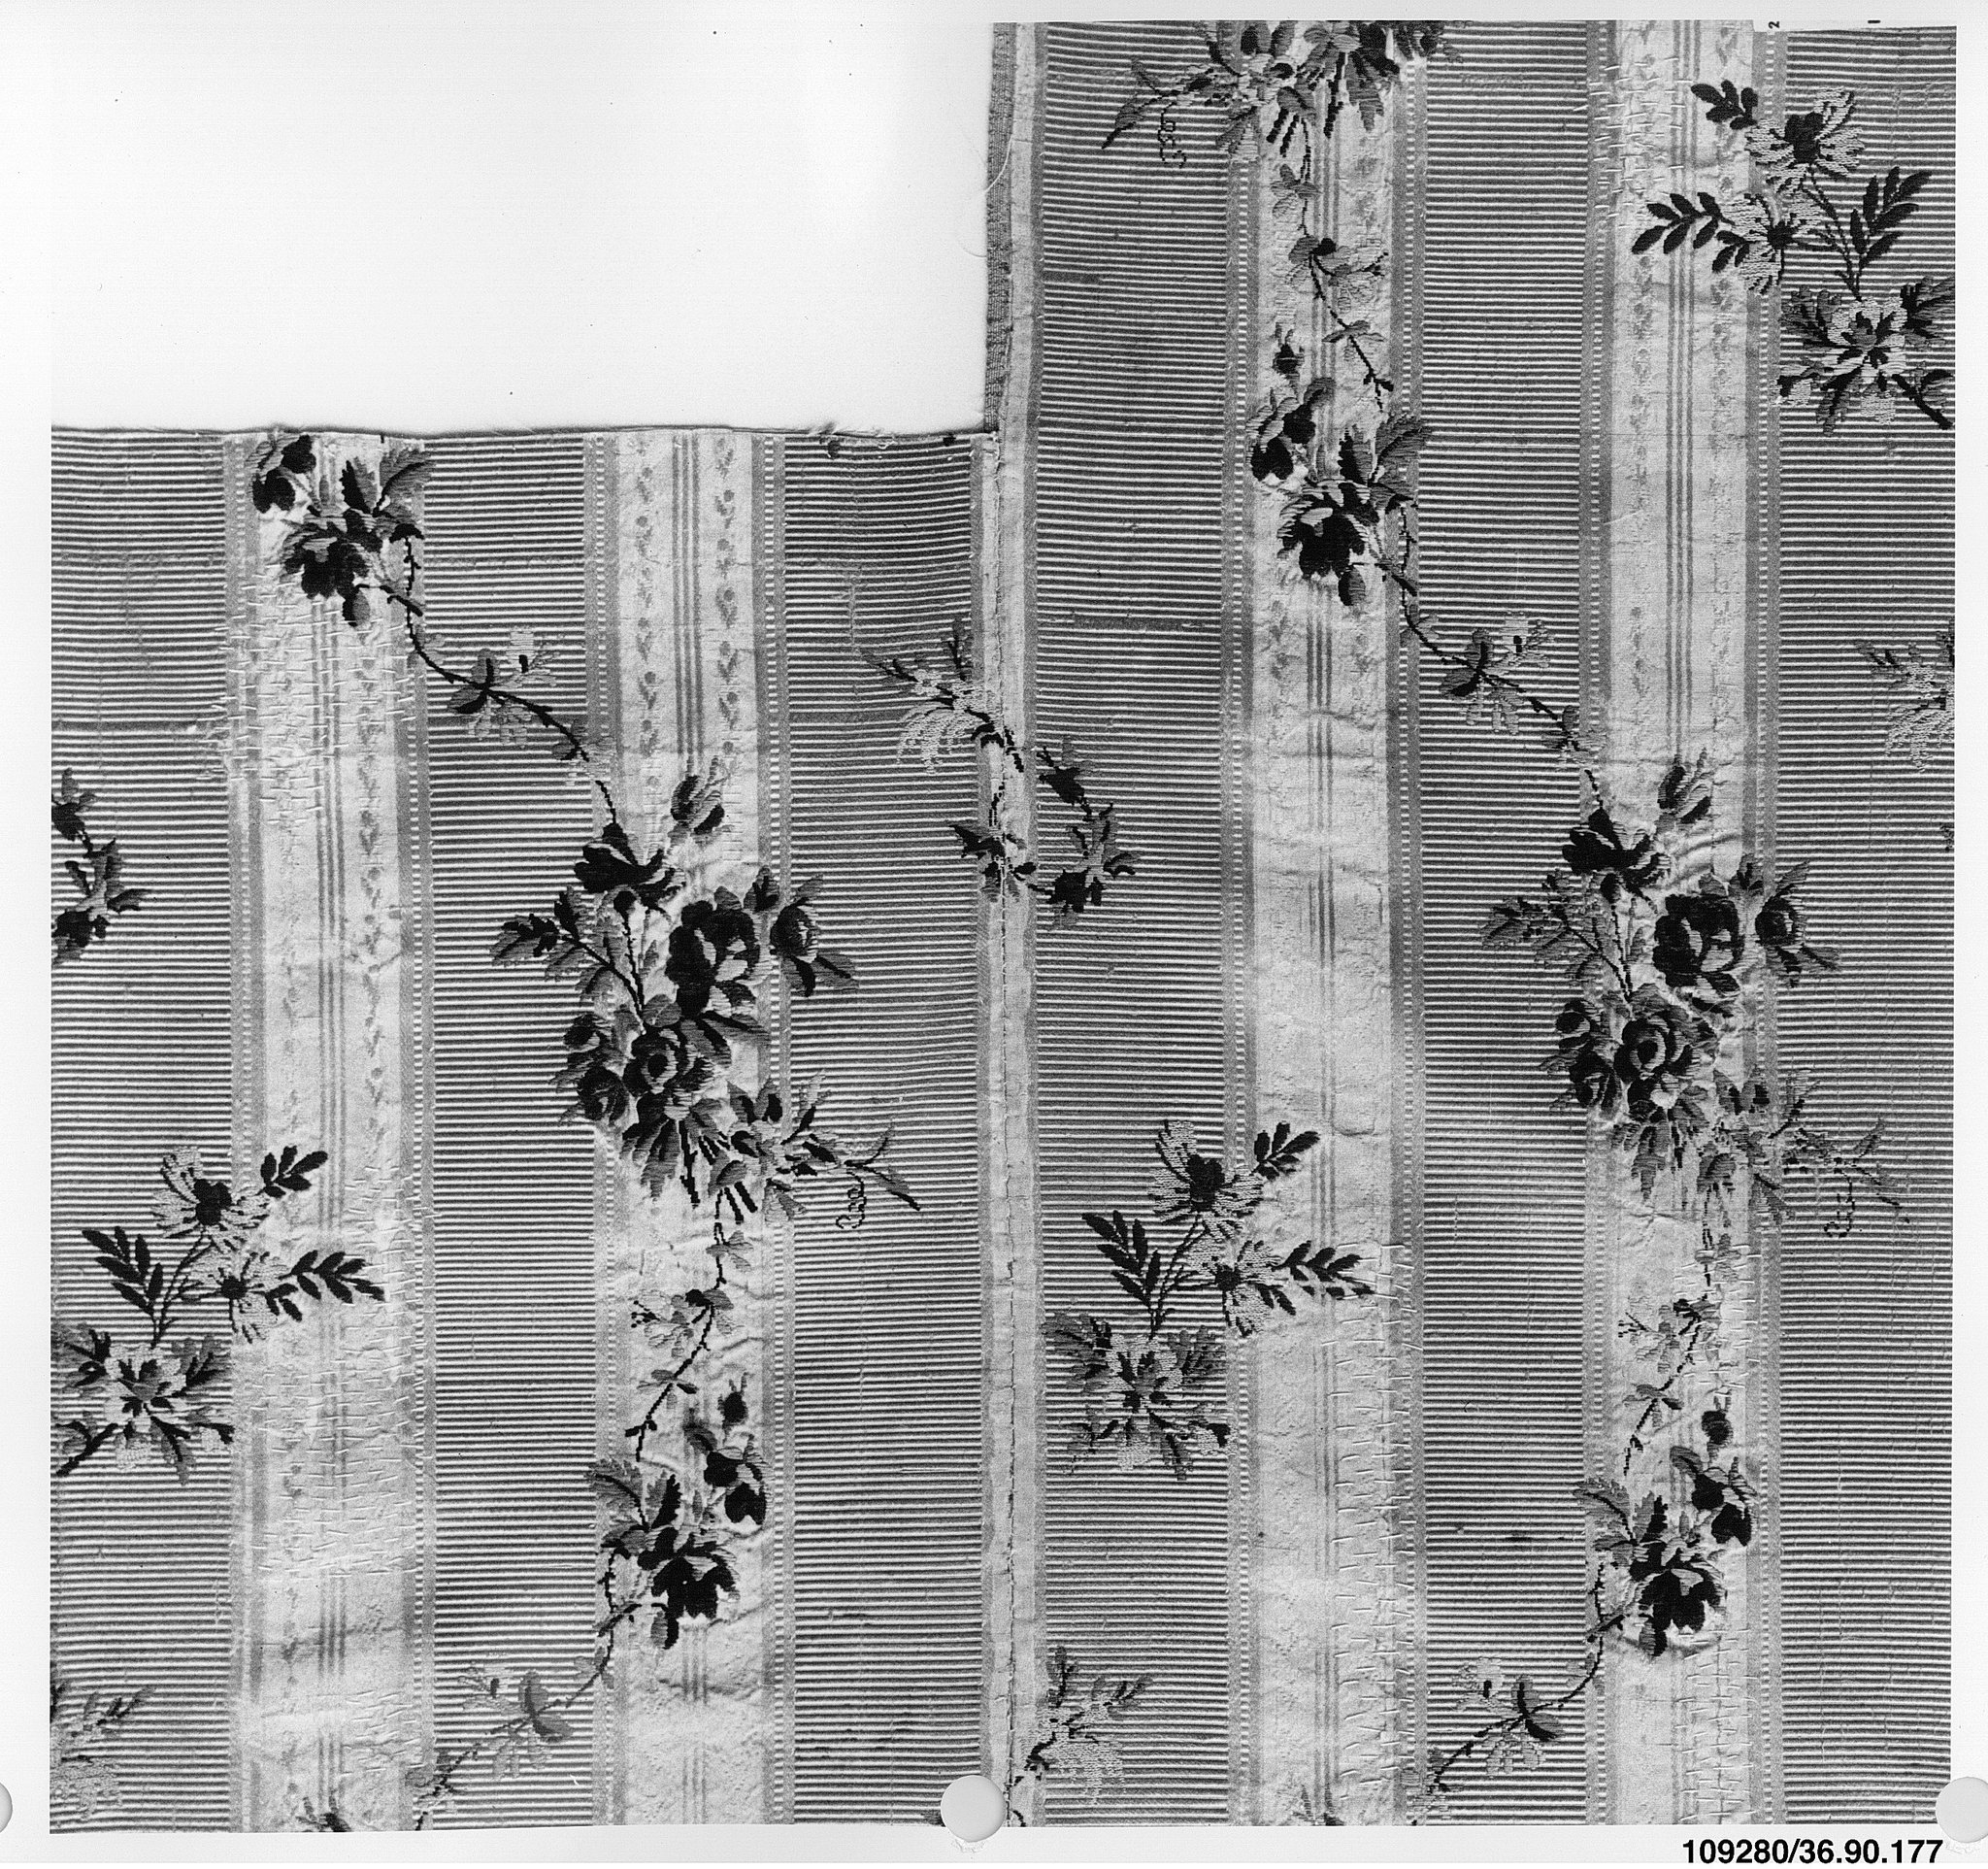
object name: piece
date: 1701-1800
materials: silk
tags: flowers,leaves